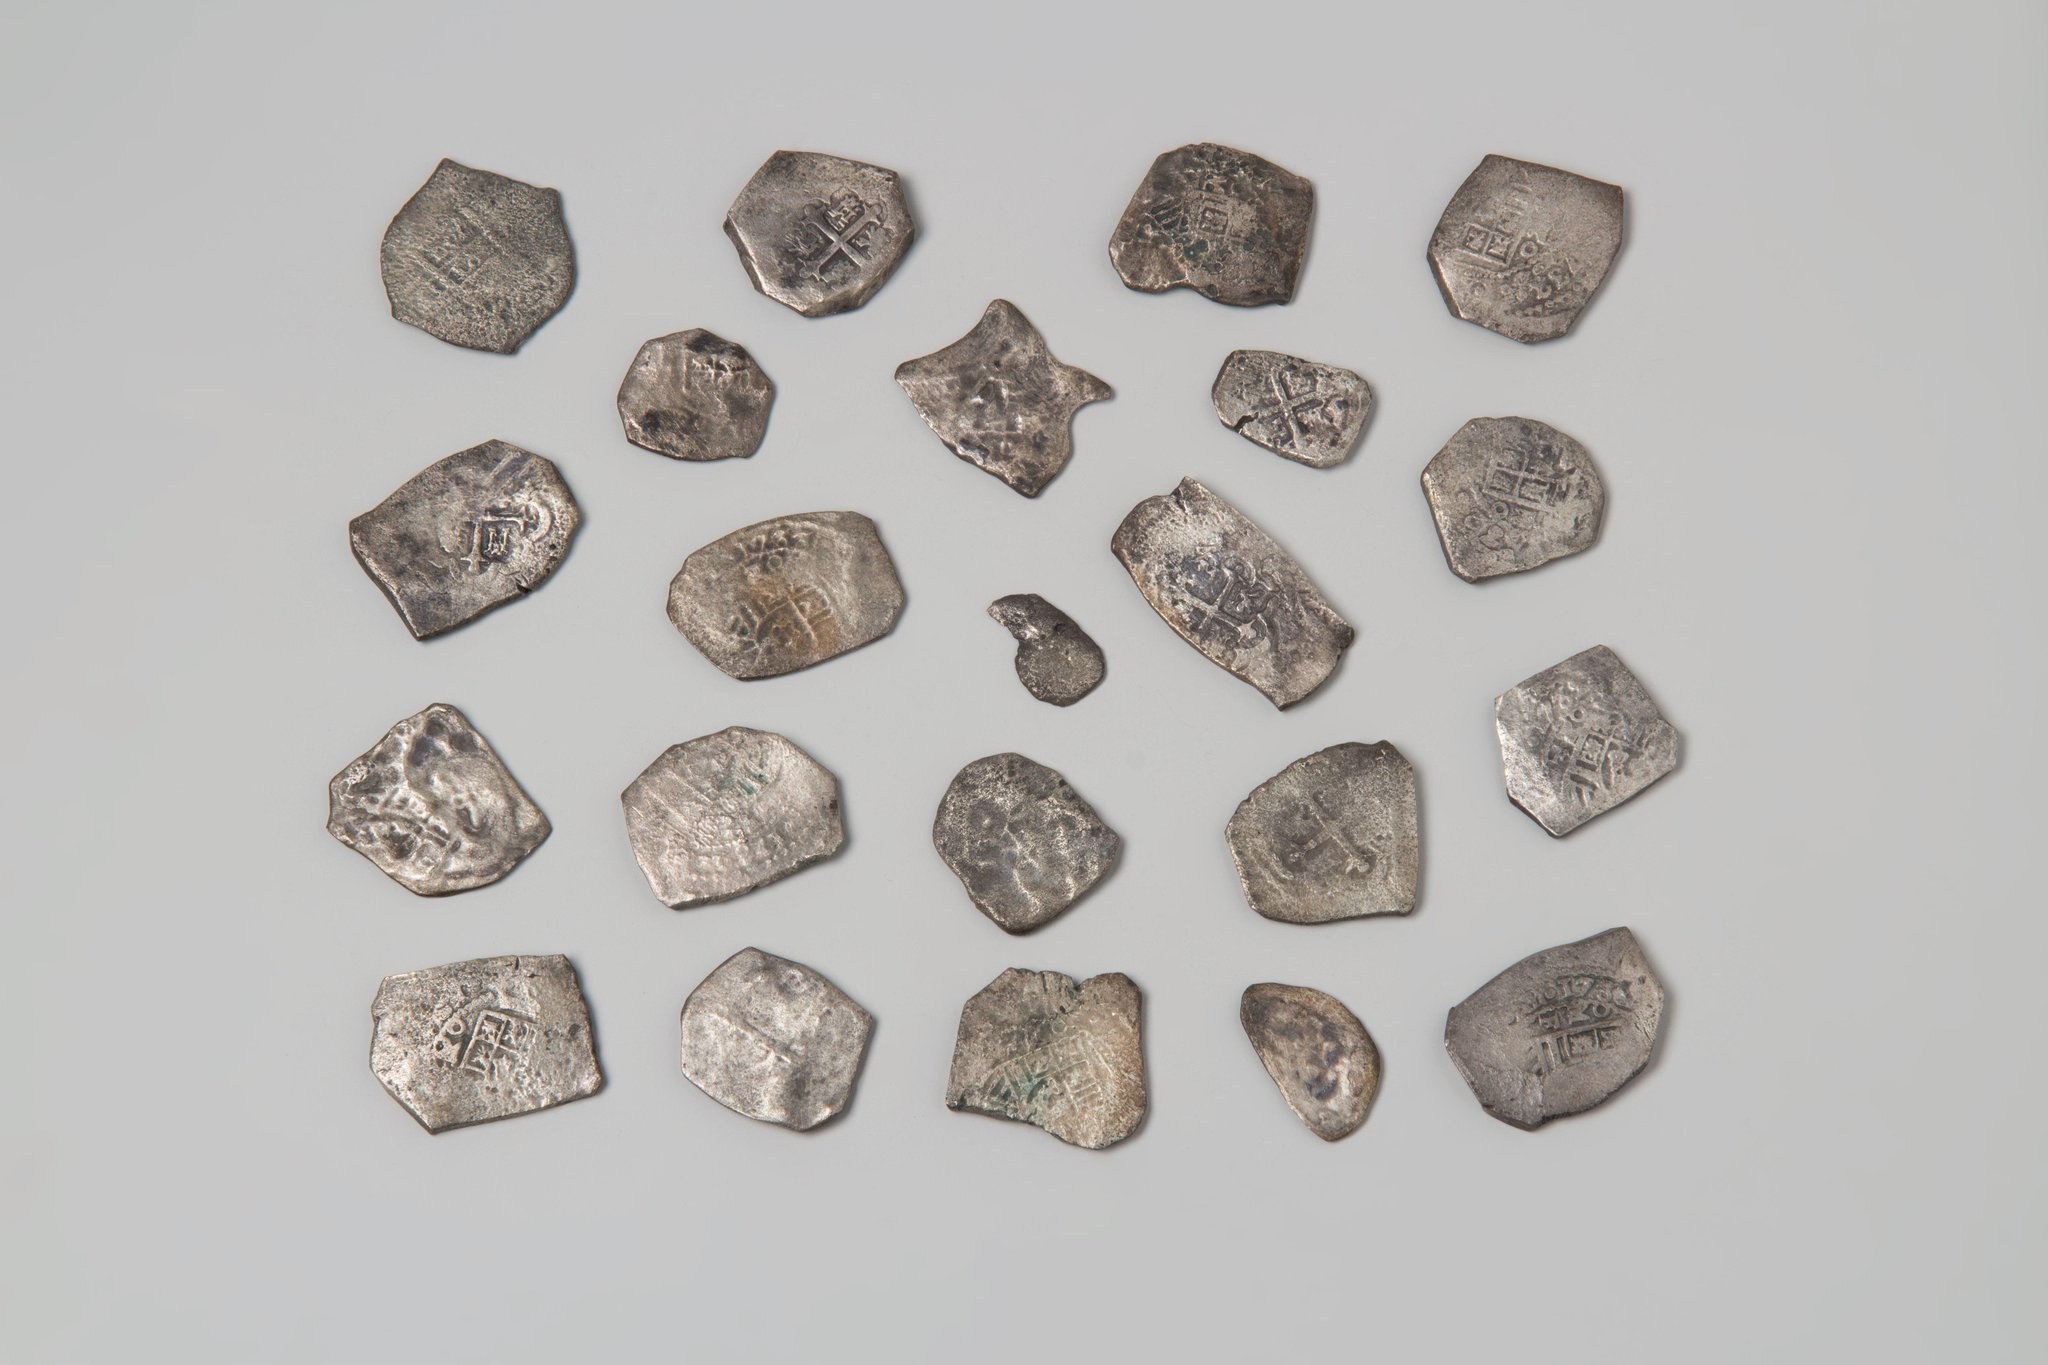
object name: vier reaal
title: Hispanic-American silver coins; eight reals and lower values; from the wreck of the Dutch East Indiaman 't Vliegend Hert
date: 1729-1733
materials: silver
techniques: striking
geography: mexico city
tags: 't vliegend hart (schip), verenigde oostindische compagnie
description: Tweeëntwintig zilveren acht-realen en onderdelen, in Spaans Amerika geslagen munten. Deze zijn min of meer rechthoekig van vorm. De onregelmatigheid komt omdat ze met de hand uit een plaat zilver werden geknipt. Veel van deze munten zijn in het zeewater geërodeerd. De éne zijde vertoont een kruis. De andere zijde het wapen van de koning van Spanje.